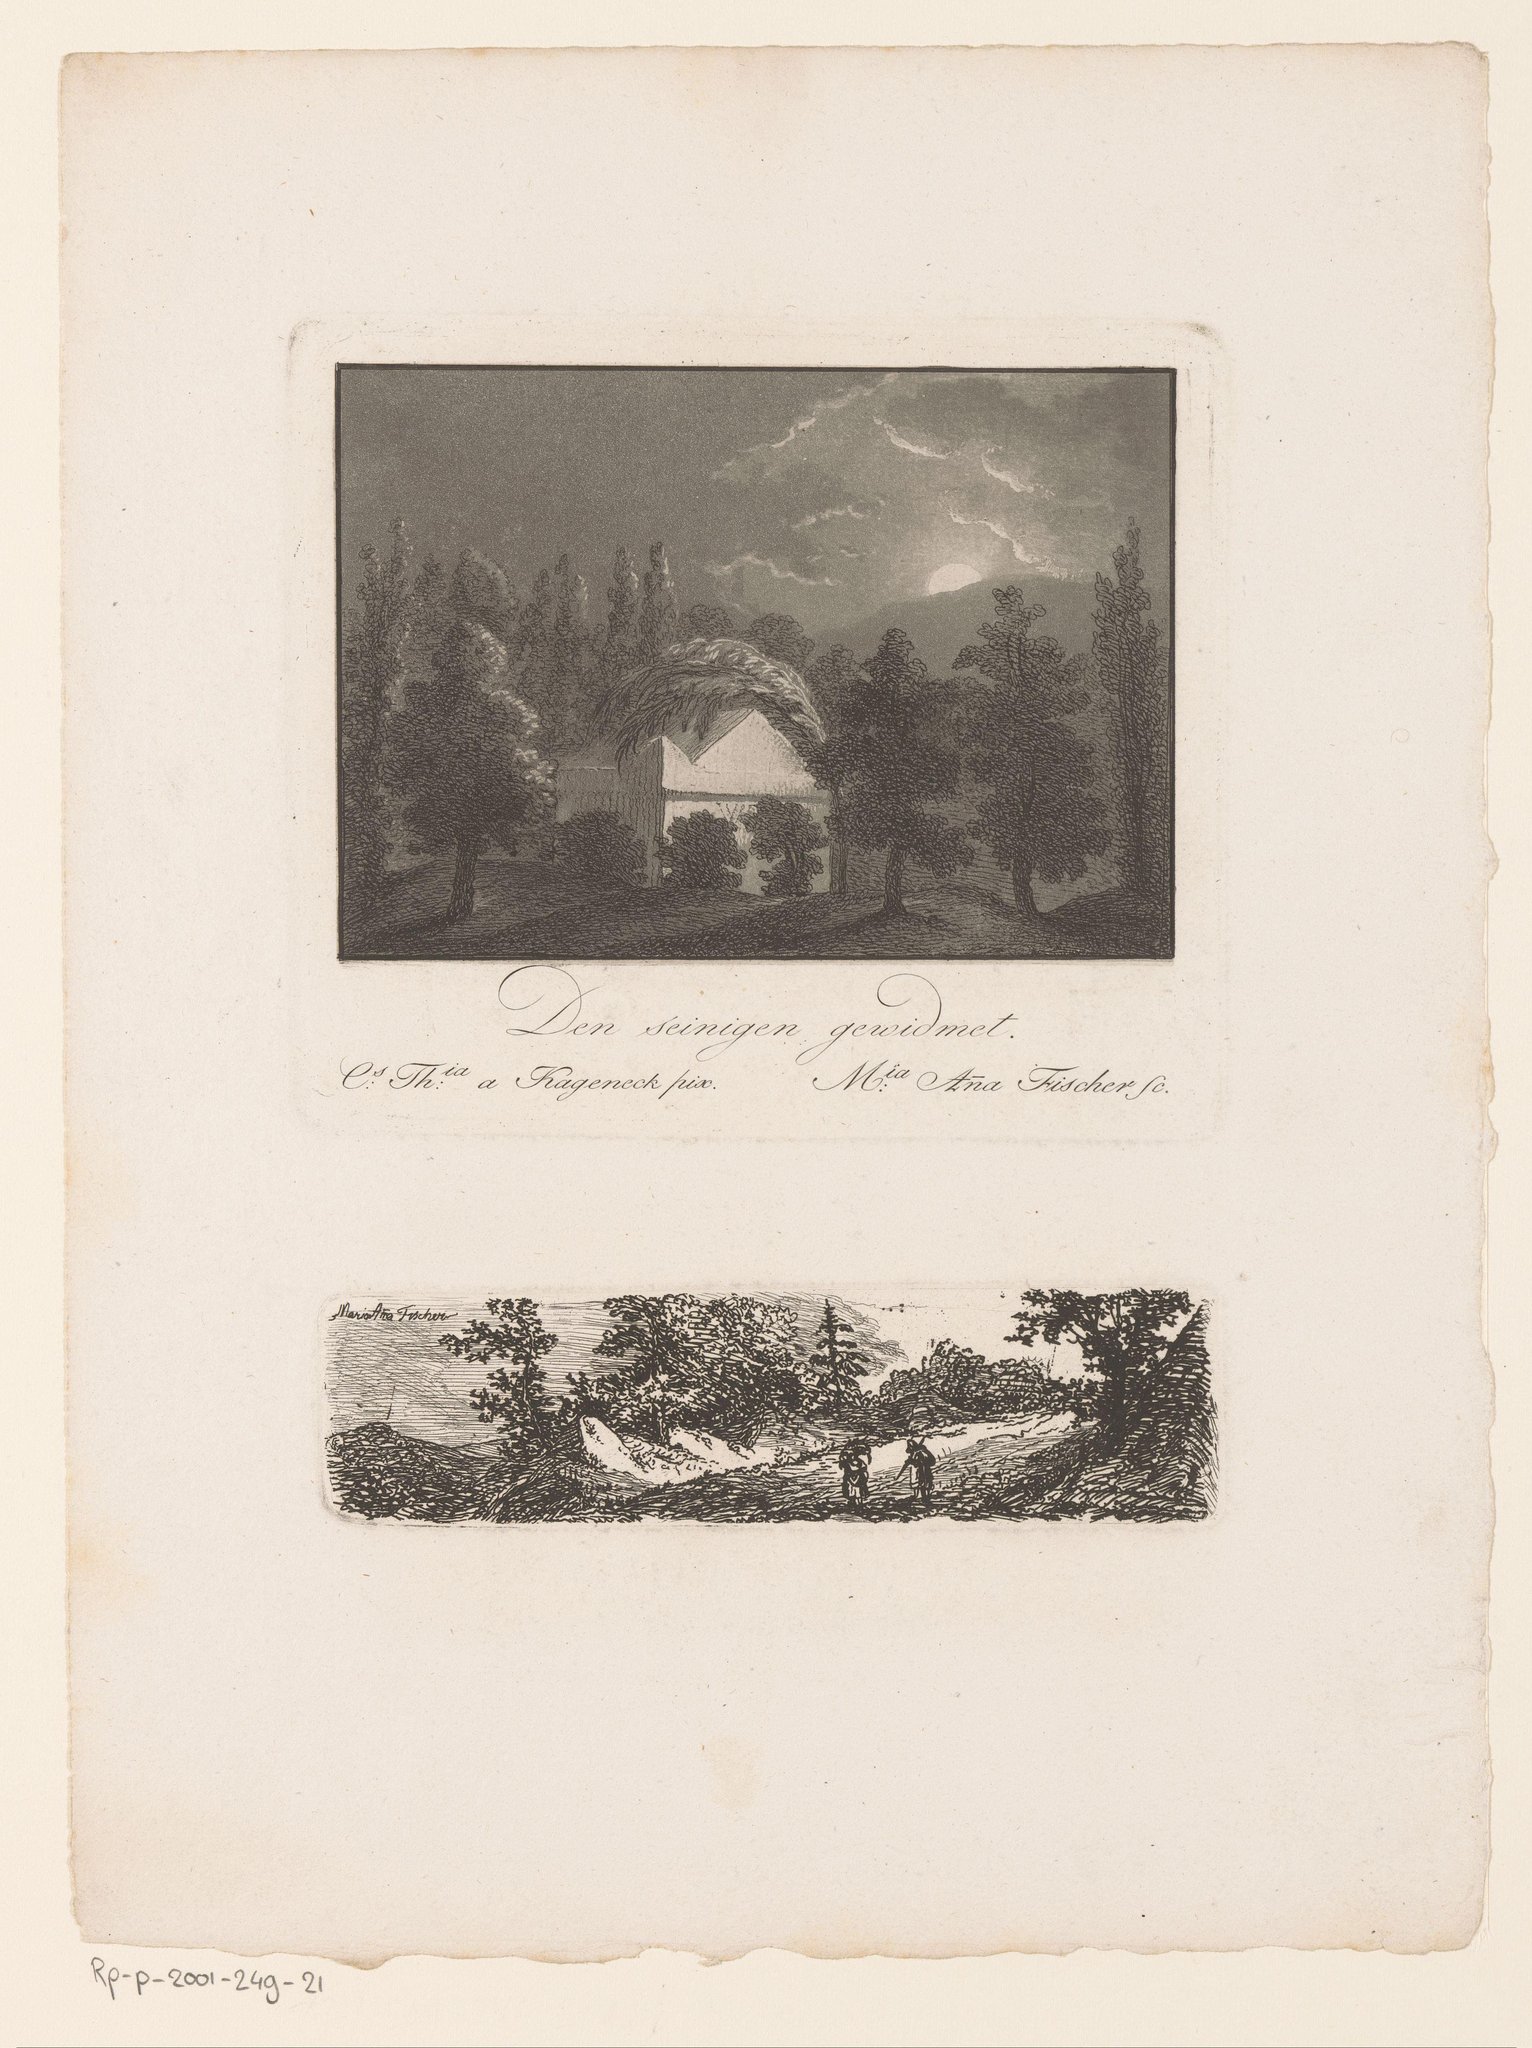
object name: print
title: Twee landschappen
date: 1804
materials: paper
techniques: aquatint, etching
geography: vienna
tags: landscapes, moonlight, road, path, 'en route', traveller under way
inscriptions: collector's mark: Lugt 2760, collector's mark: Lugt 2228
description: De originele prentserie bevat 40 prenten op 28 bladen. Het RMA heeft 33 prenten op 22 bladen in de collectie.